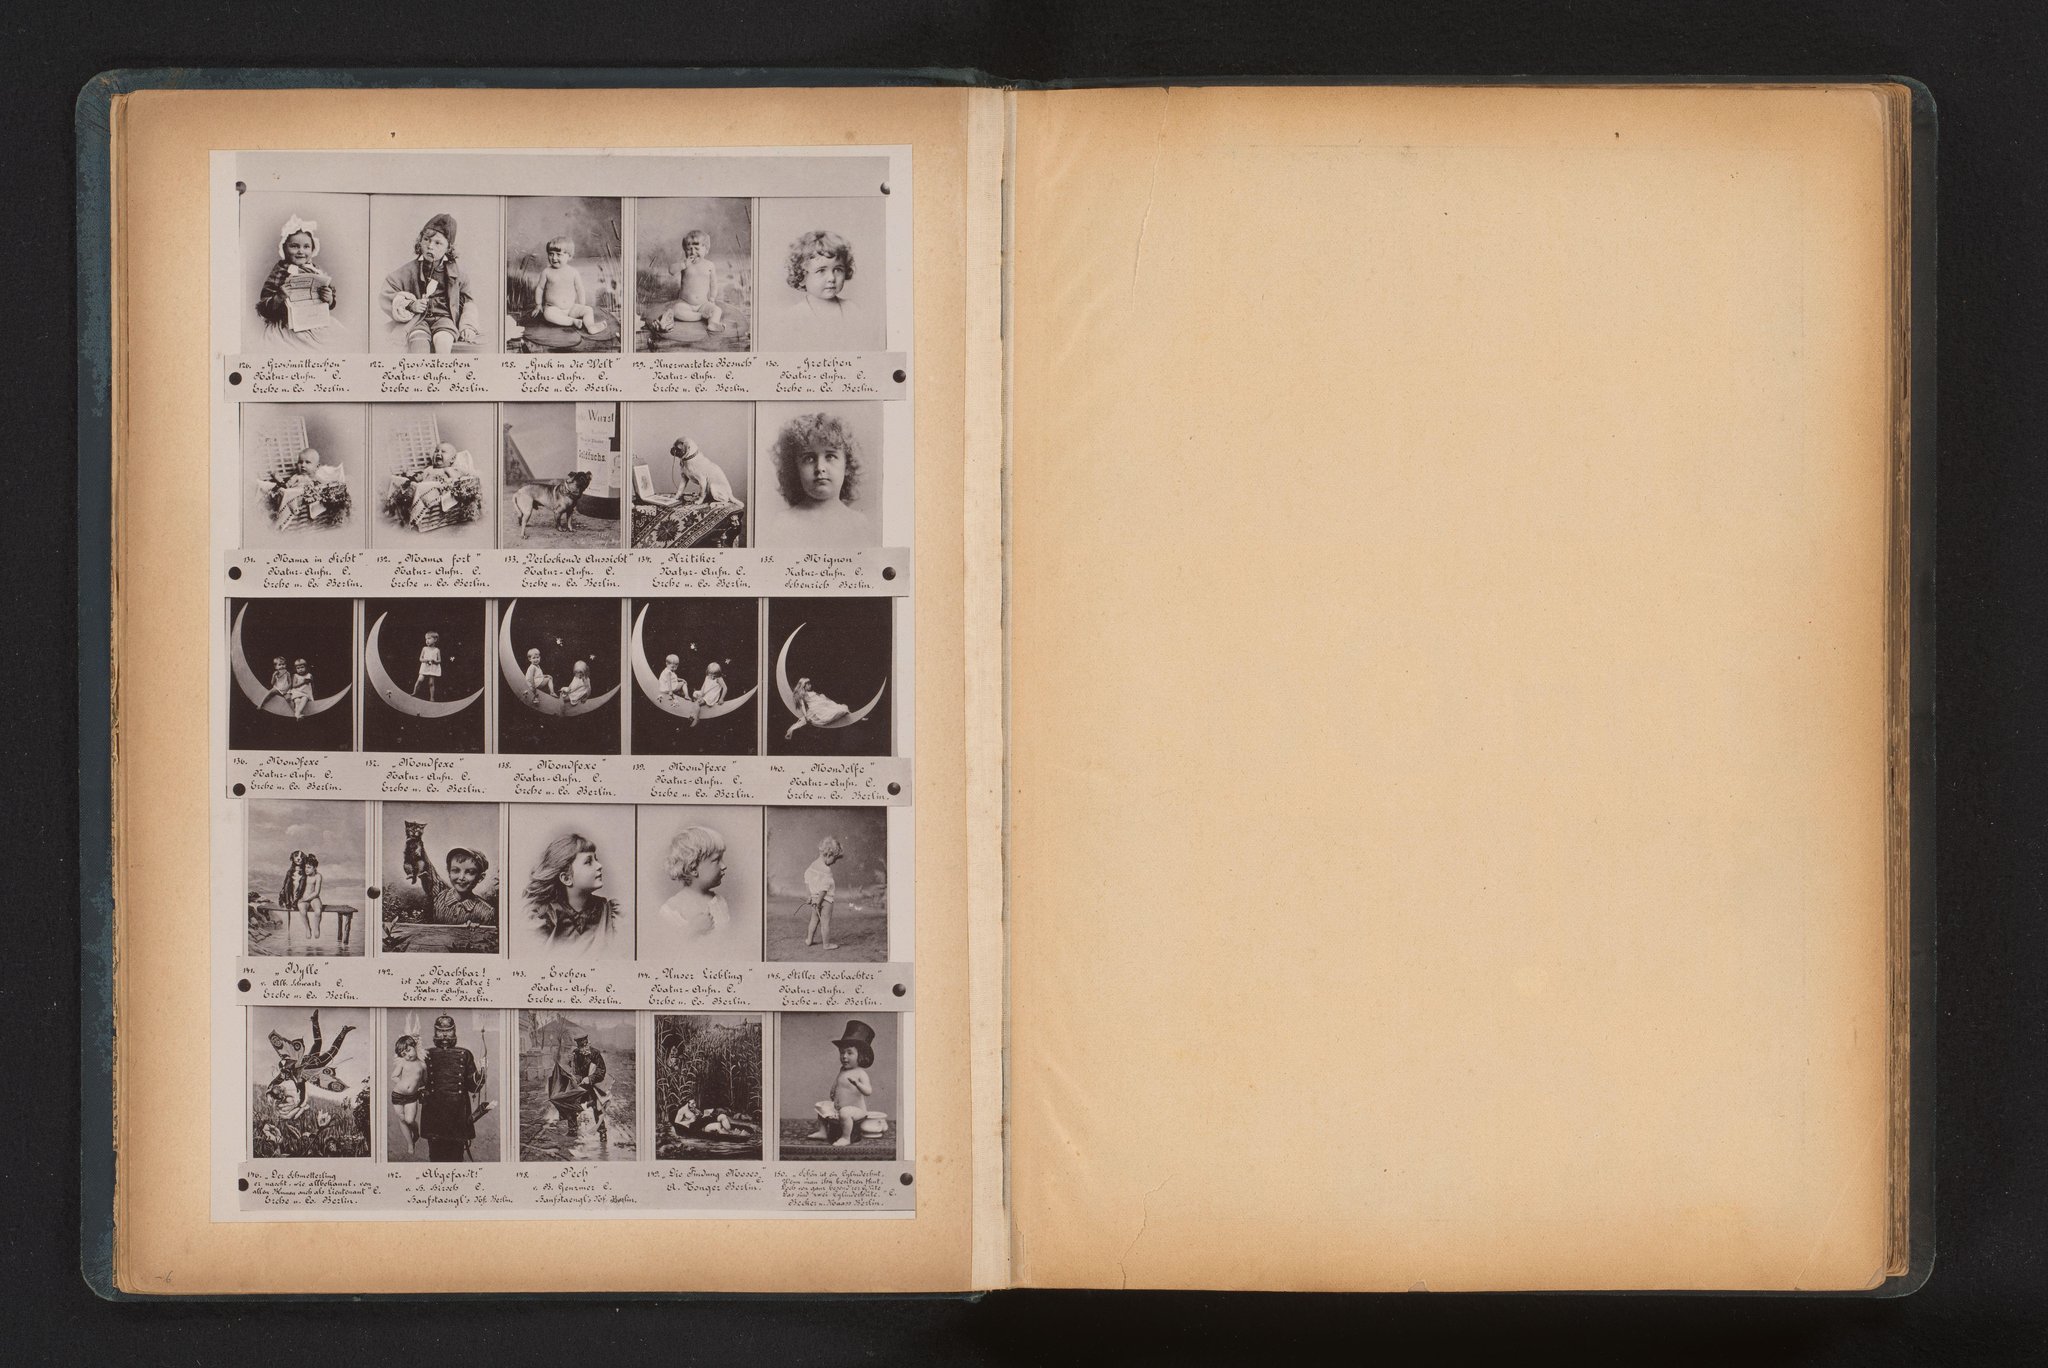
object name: photomechanical print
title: Fotoreproducties van 6 geschilderde taferelen en 19 portretten van onbekende kinderen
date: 1880-1885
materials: paper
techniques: photograph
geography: berlin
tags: child, anonymous historical person portrayed